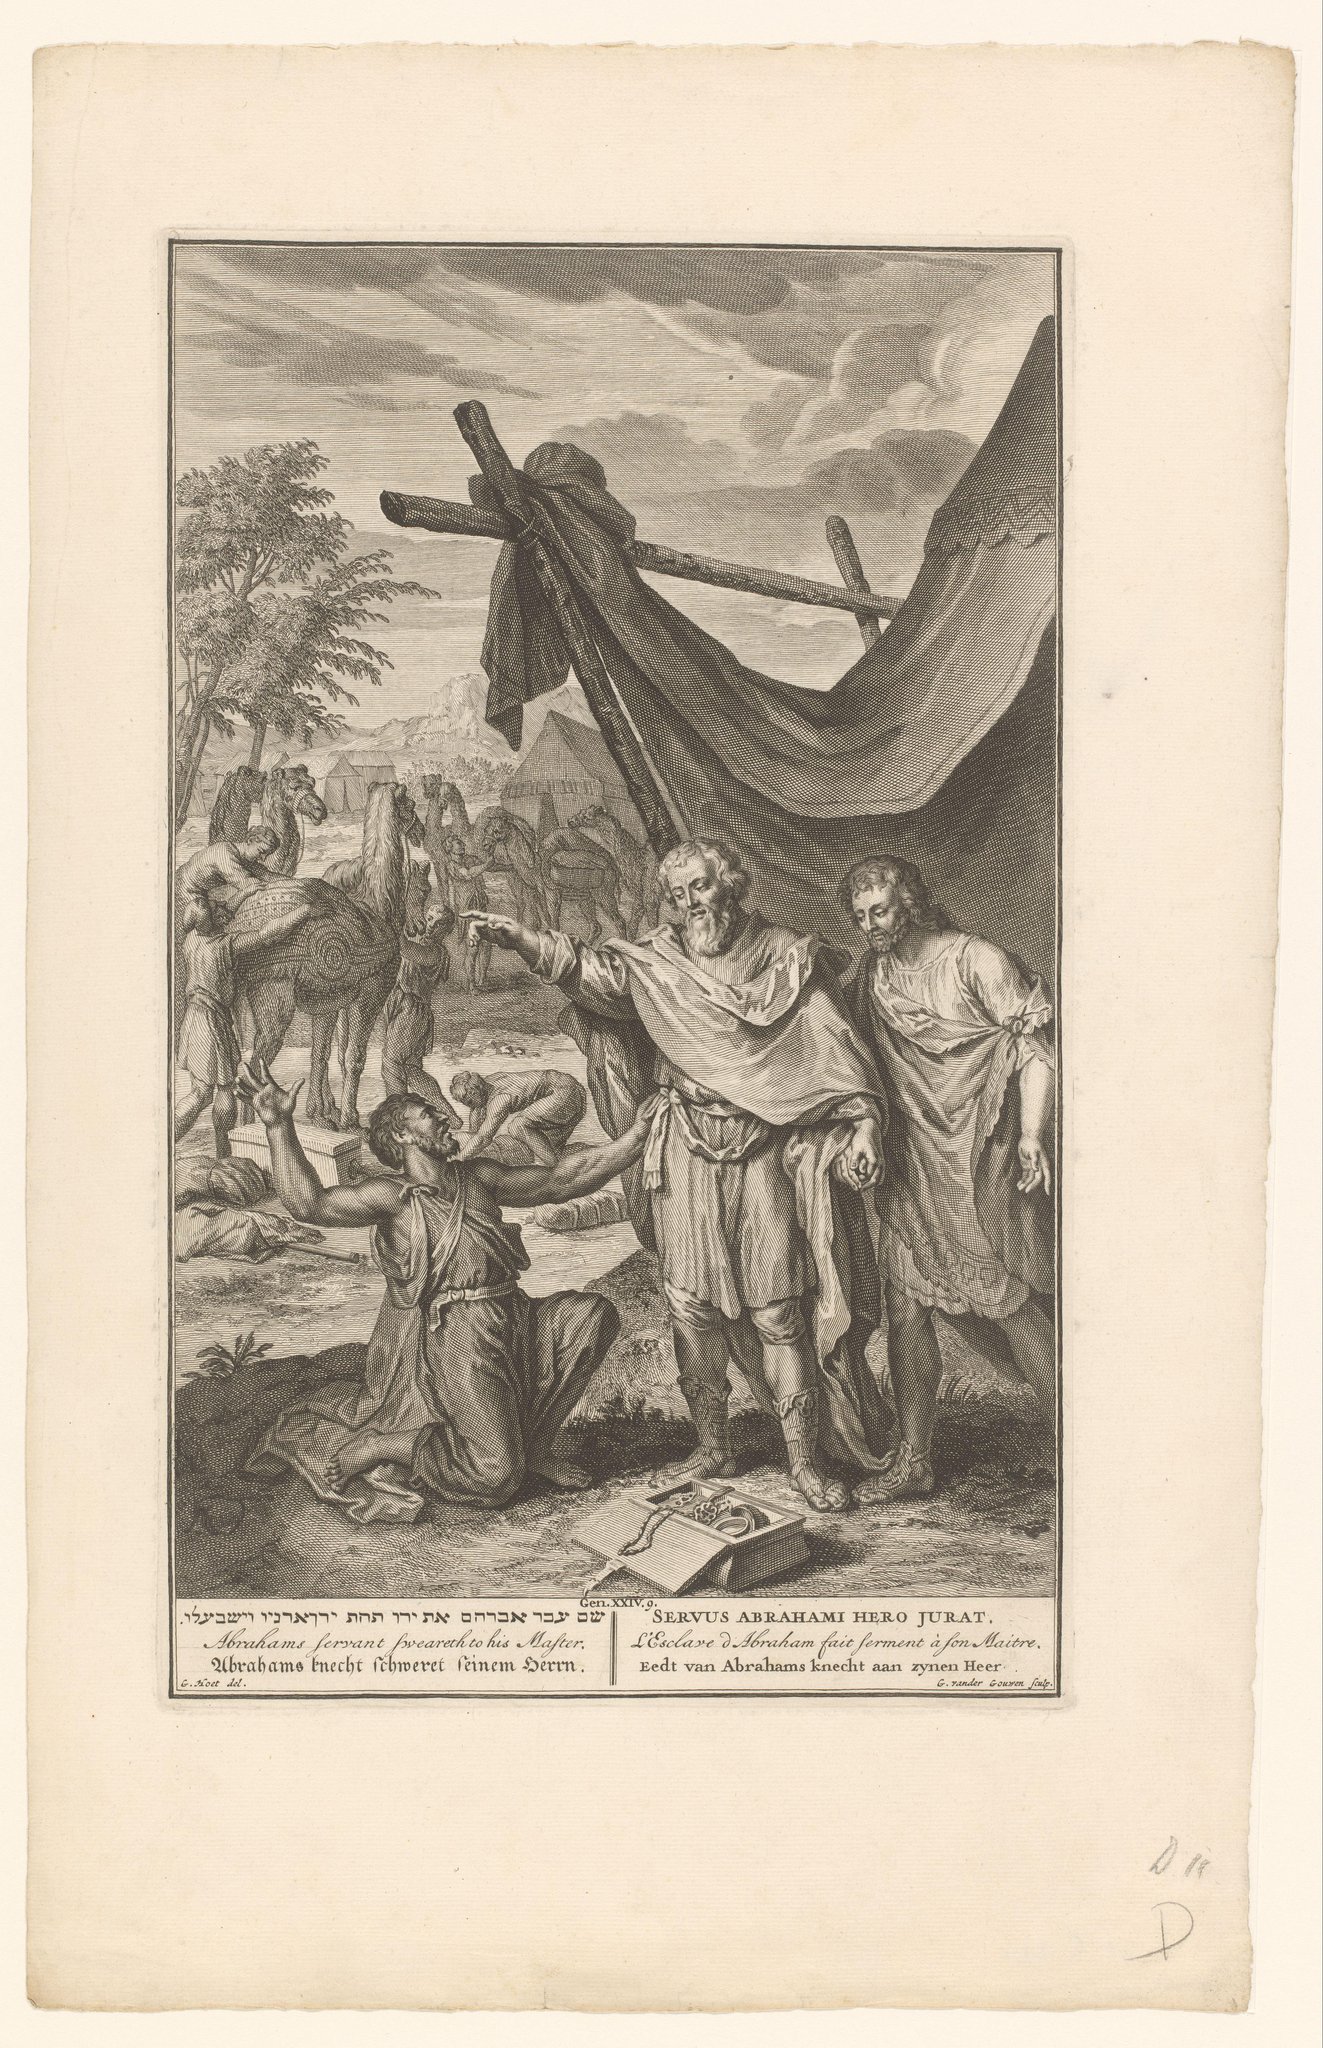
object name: print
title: Eliëzer belooft dat hij een vrouw voor Isaak zal vinden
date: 1720-1728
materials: paper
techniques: engraving, etching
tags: eliezer taking the oath: abraham sends him to his relatives in mesopotamia to find a wife for isaac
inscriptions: inscription: ‘ütrechts Fündatie hüijs’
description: Prent gemaakt voor: Figures de la Bible. Amsterdam: Bernard Picart, 1720. Prent ook gebruikt in: Taferelen der voornaamste geschiedenissen van het Oude en Nieuwe Testament (...) door de vermaarde kunstenaars Hoet, Houbraken, en Picart getekent (...) en met beschrijvingen uitgebreid. Den Haag: Pieter de Hondt, 1728.